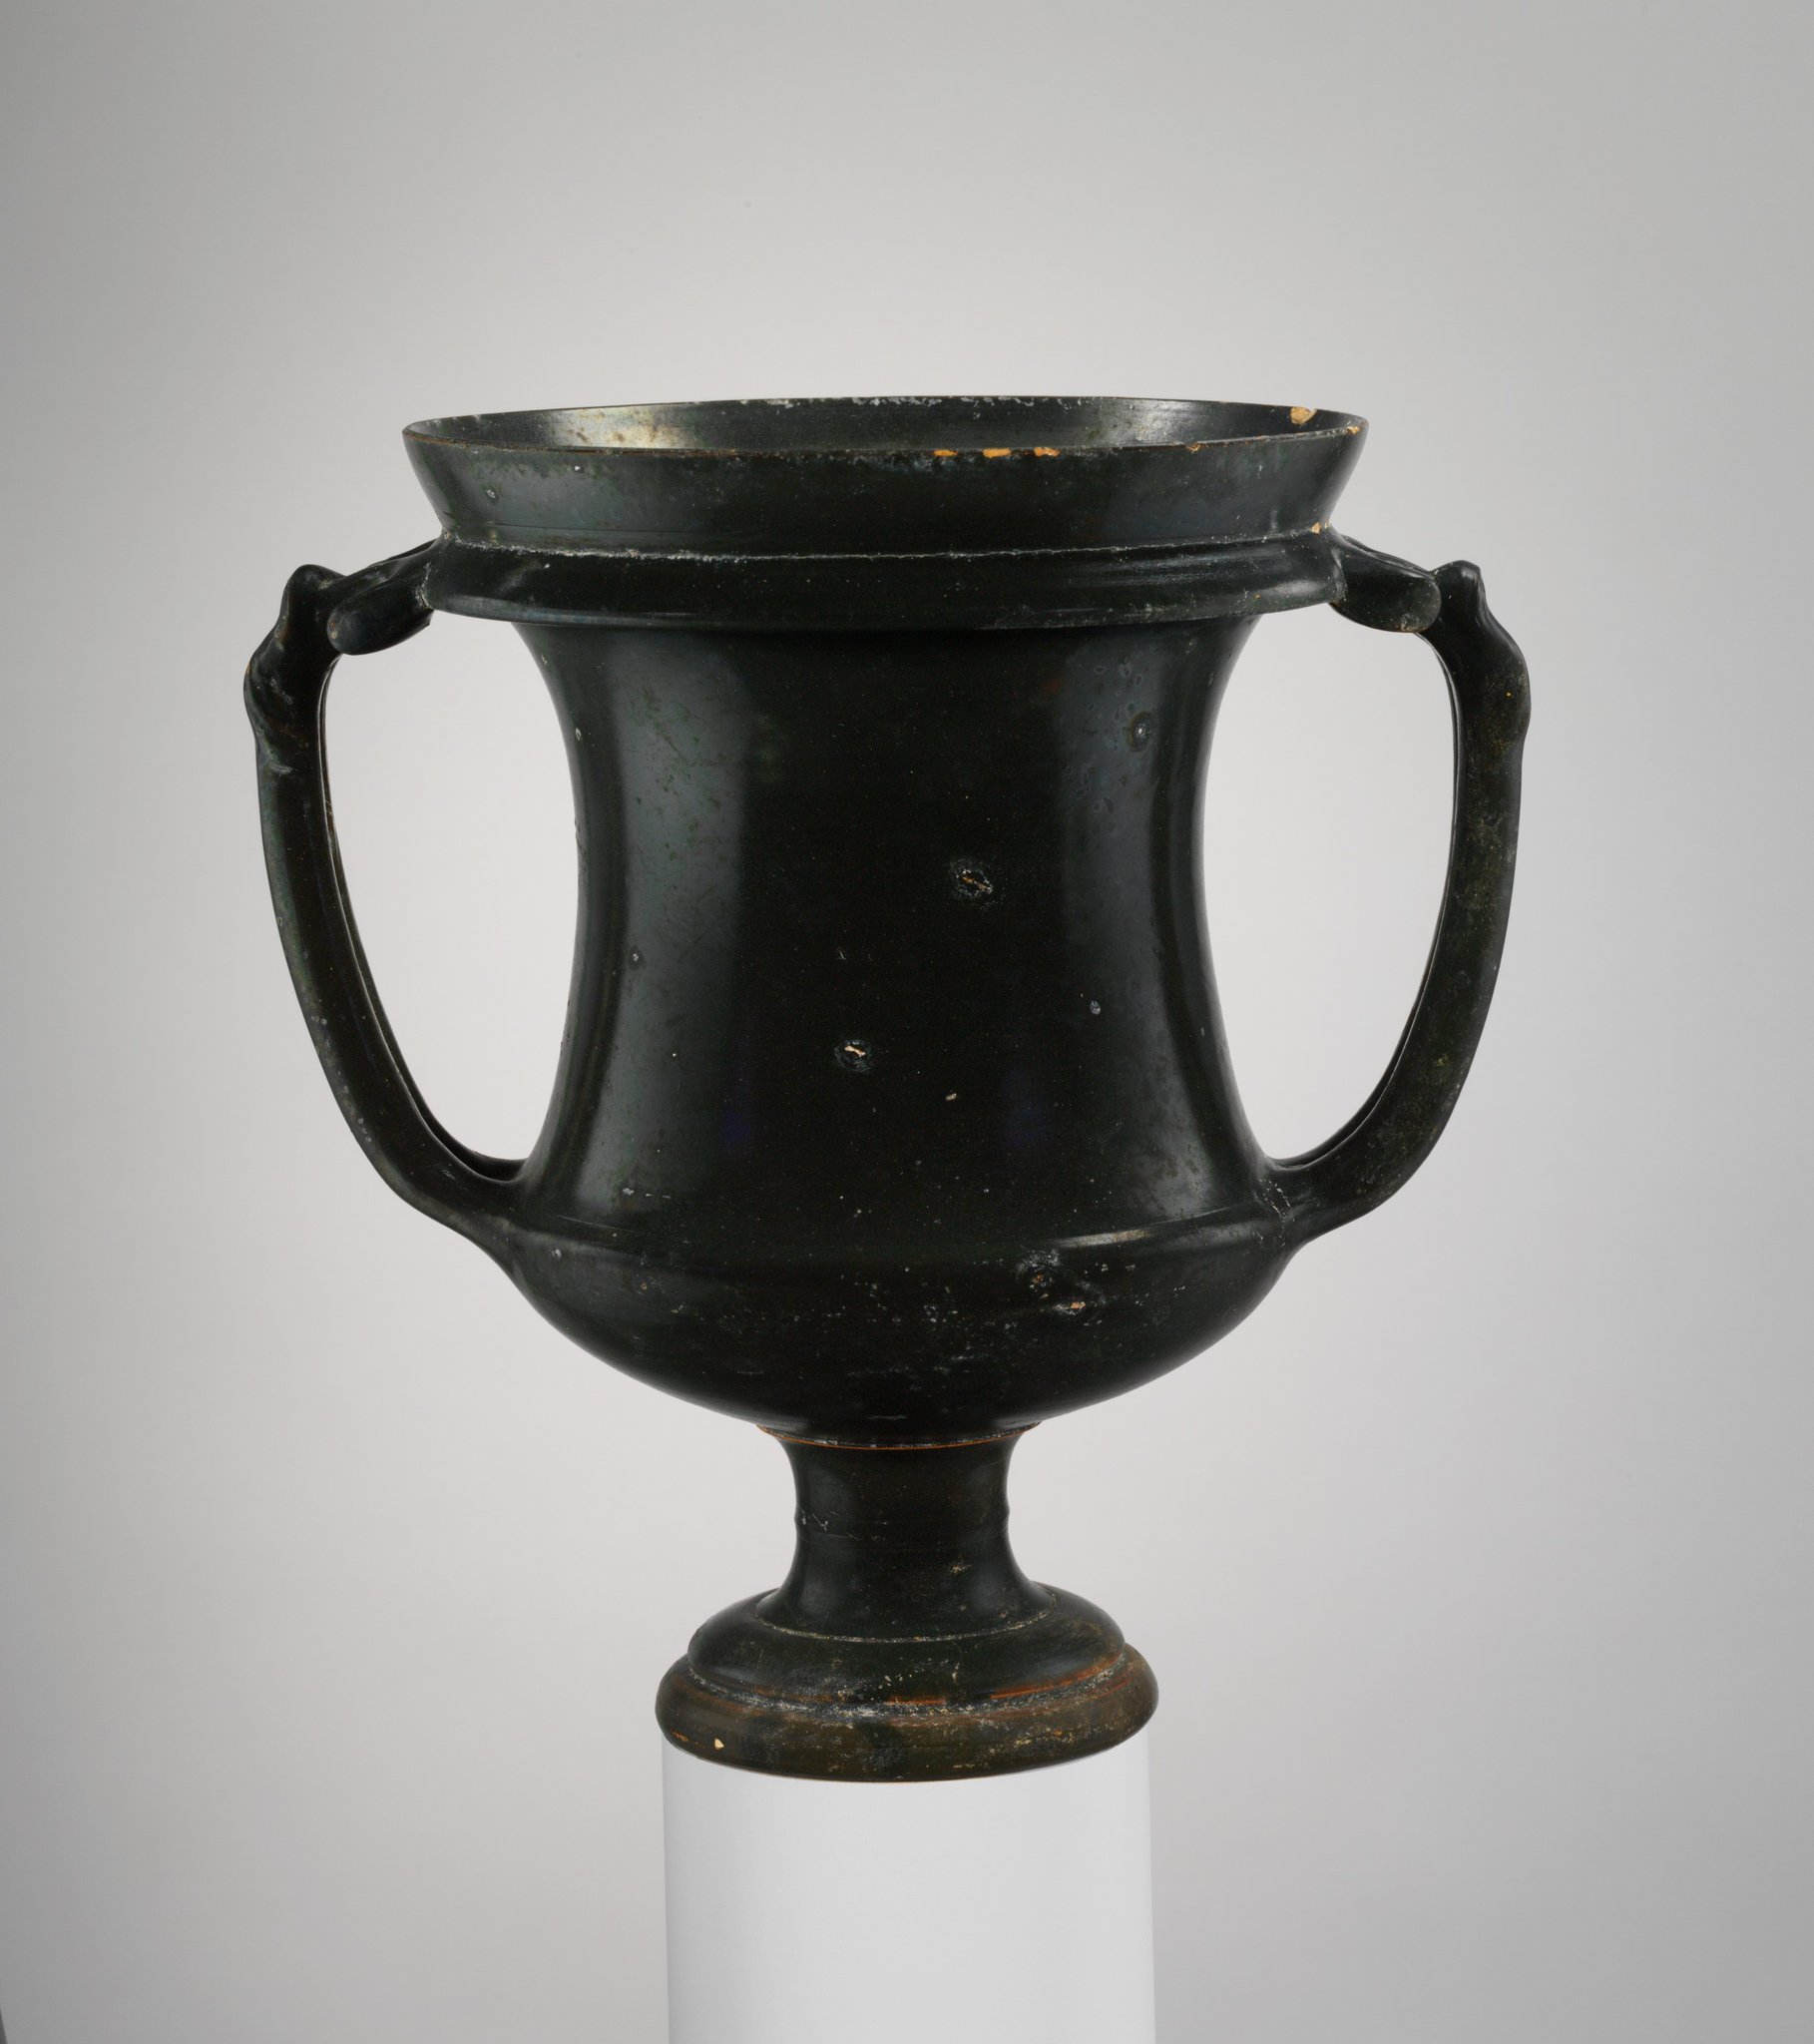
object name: kantharos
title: Terracotta kantharos (drinking cup)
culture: etruscan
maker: group of vatican g.116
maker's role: artist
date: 300 BCE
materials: terracotta